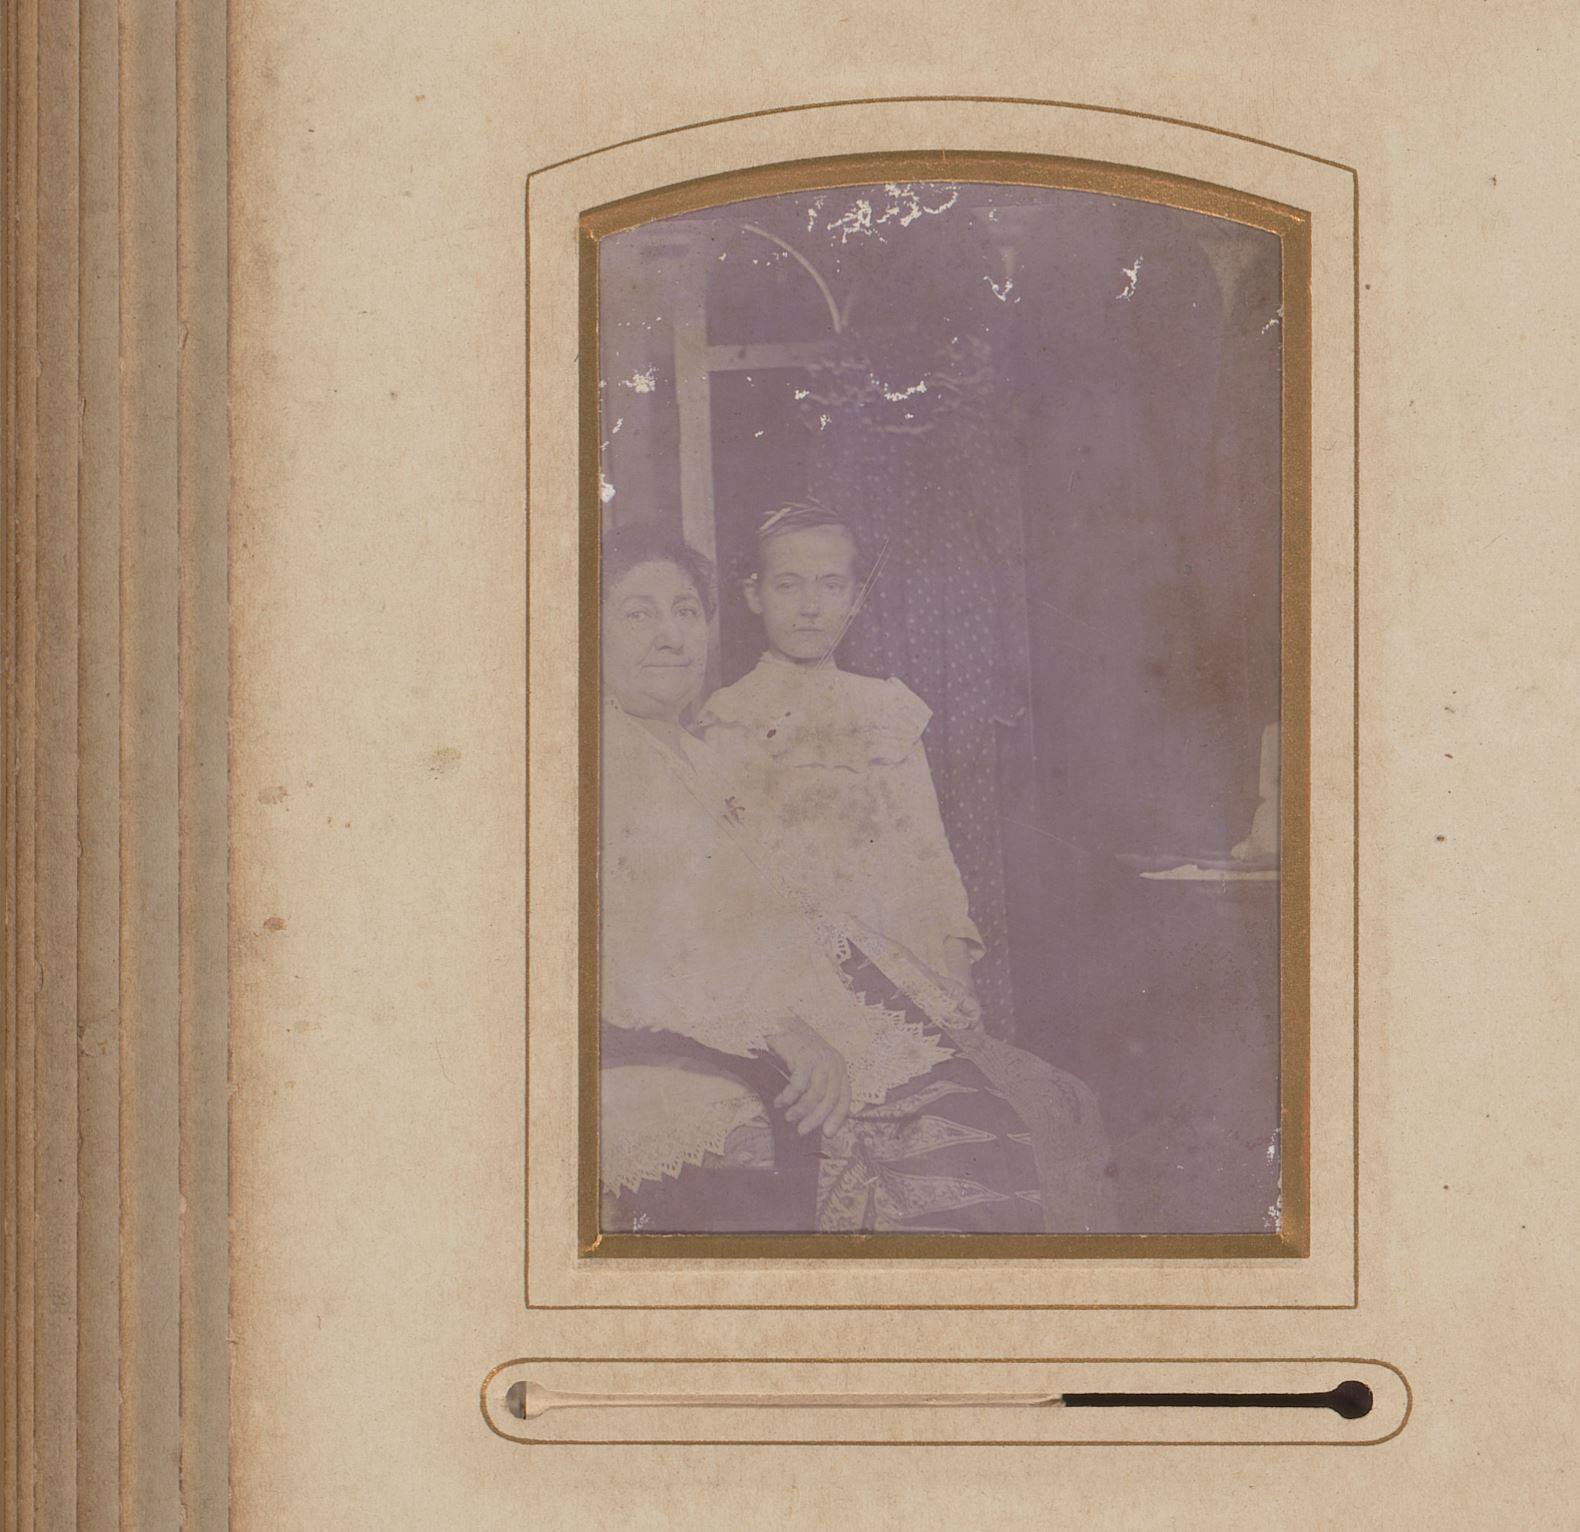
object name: album leaf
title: Portret van een zittende vrouw en een staand meisje in een interieur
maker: Anonymous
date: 1880-1920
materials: cardboard, photographic support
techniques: collodion silver print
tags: historical persons - bb - woman, girl (child between toddler and youth), interior of the house